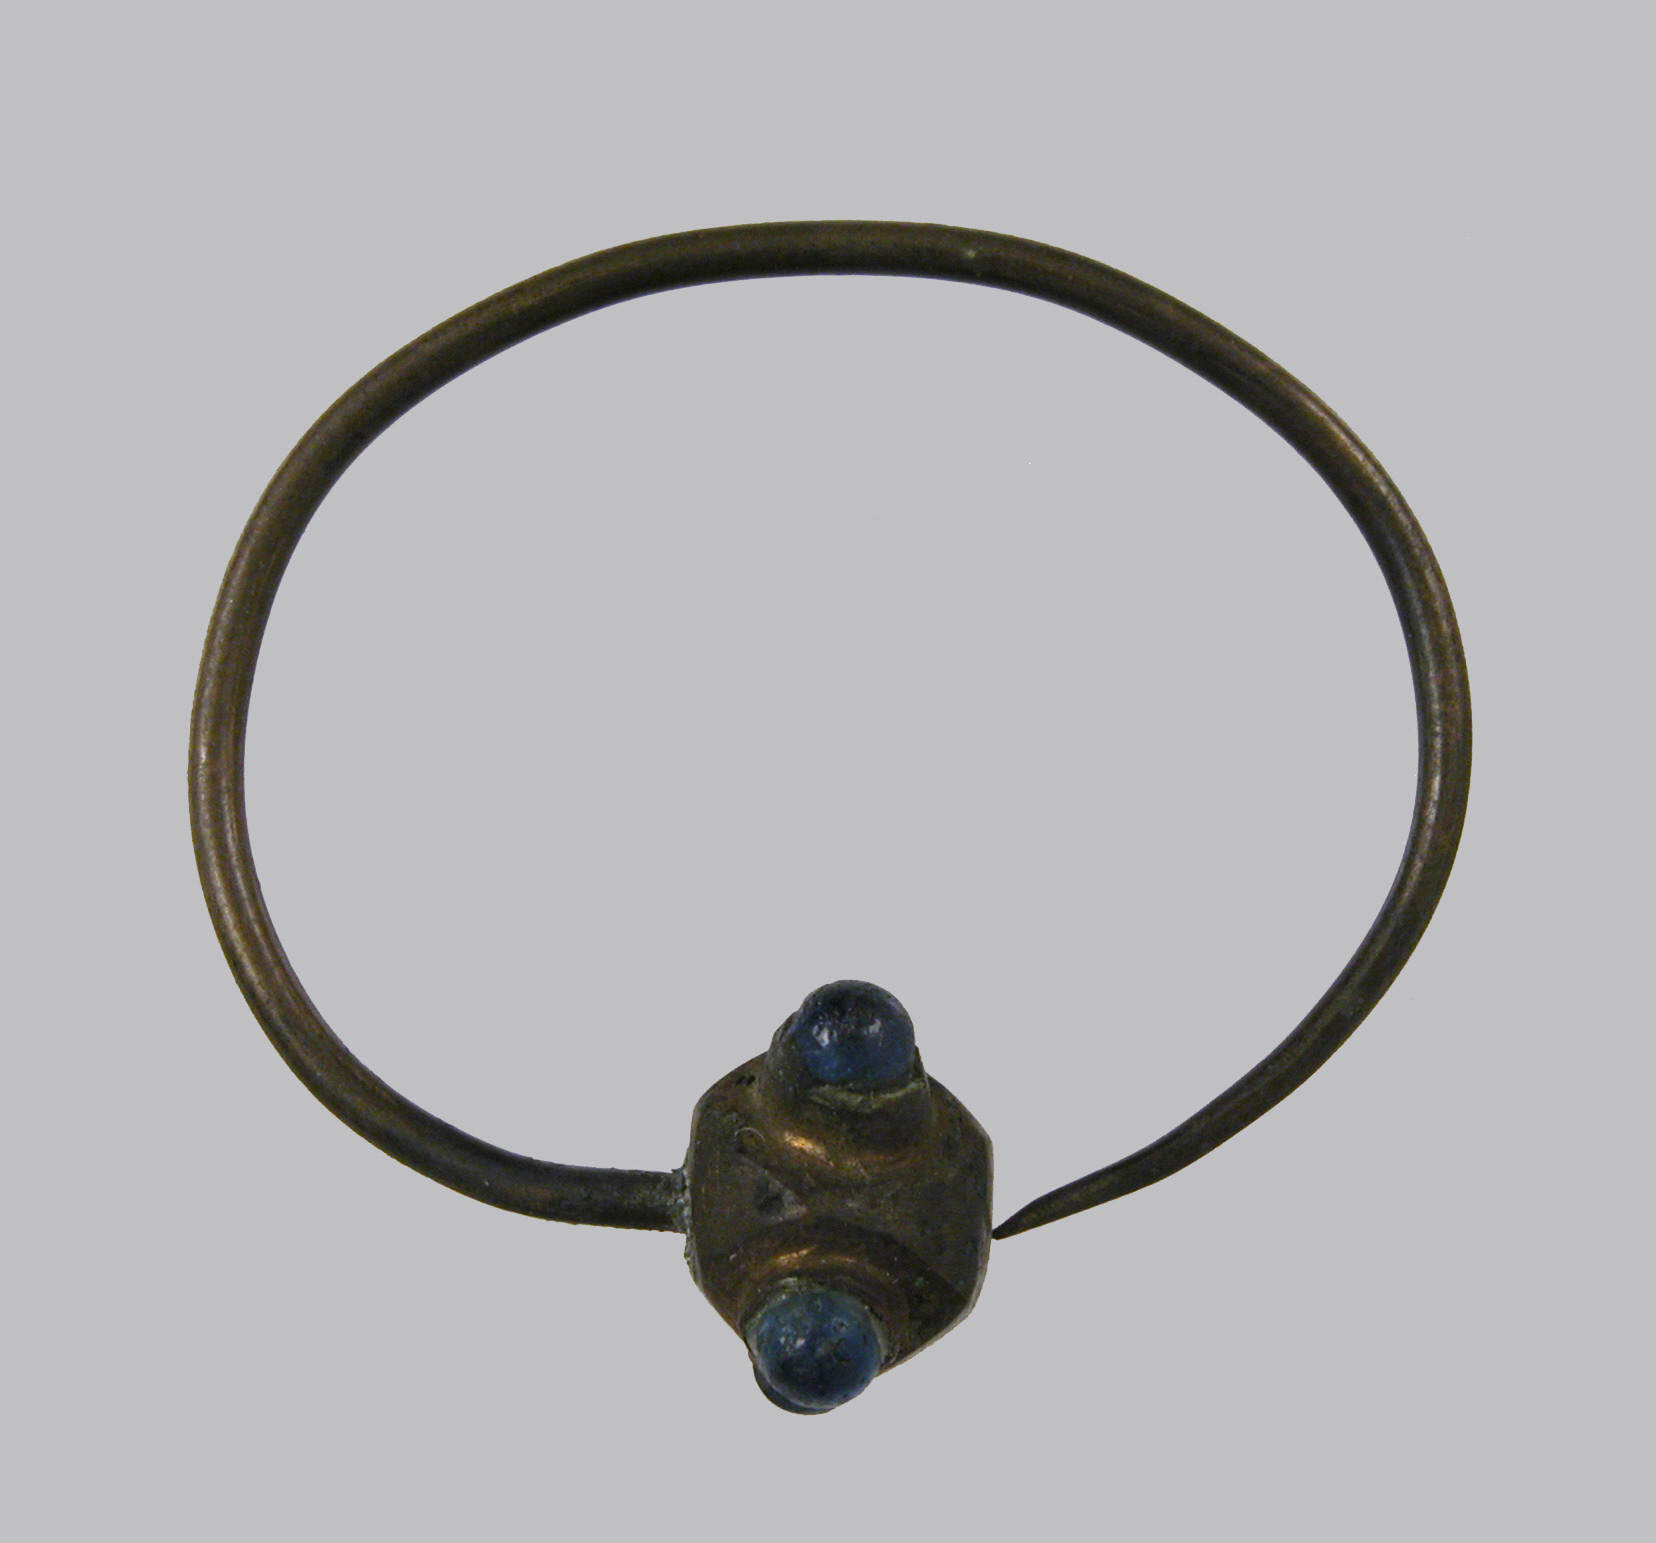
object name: earring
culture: frankish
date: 500-700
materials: copper alloy, gilt, glass, paste